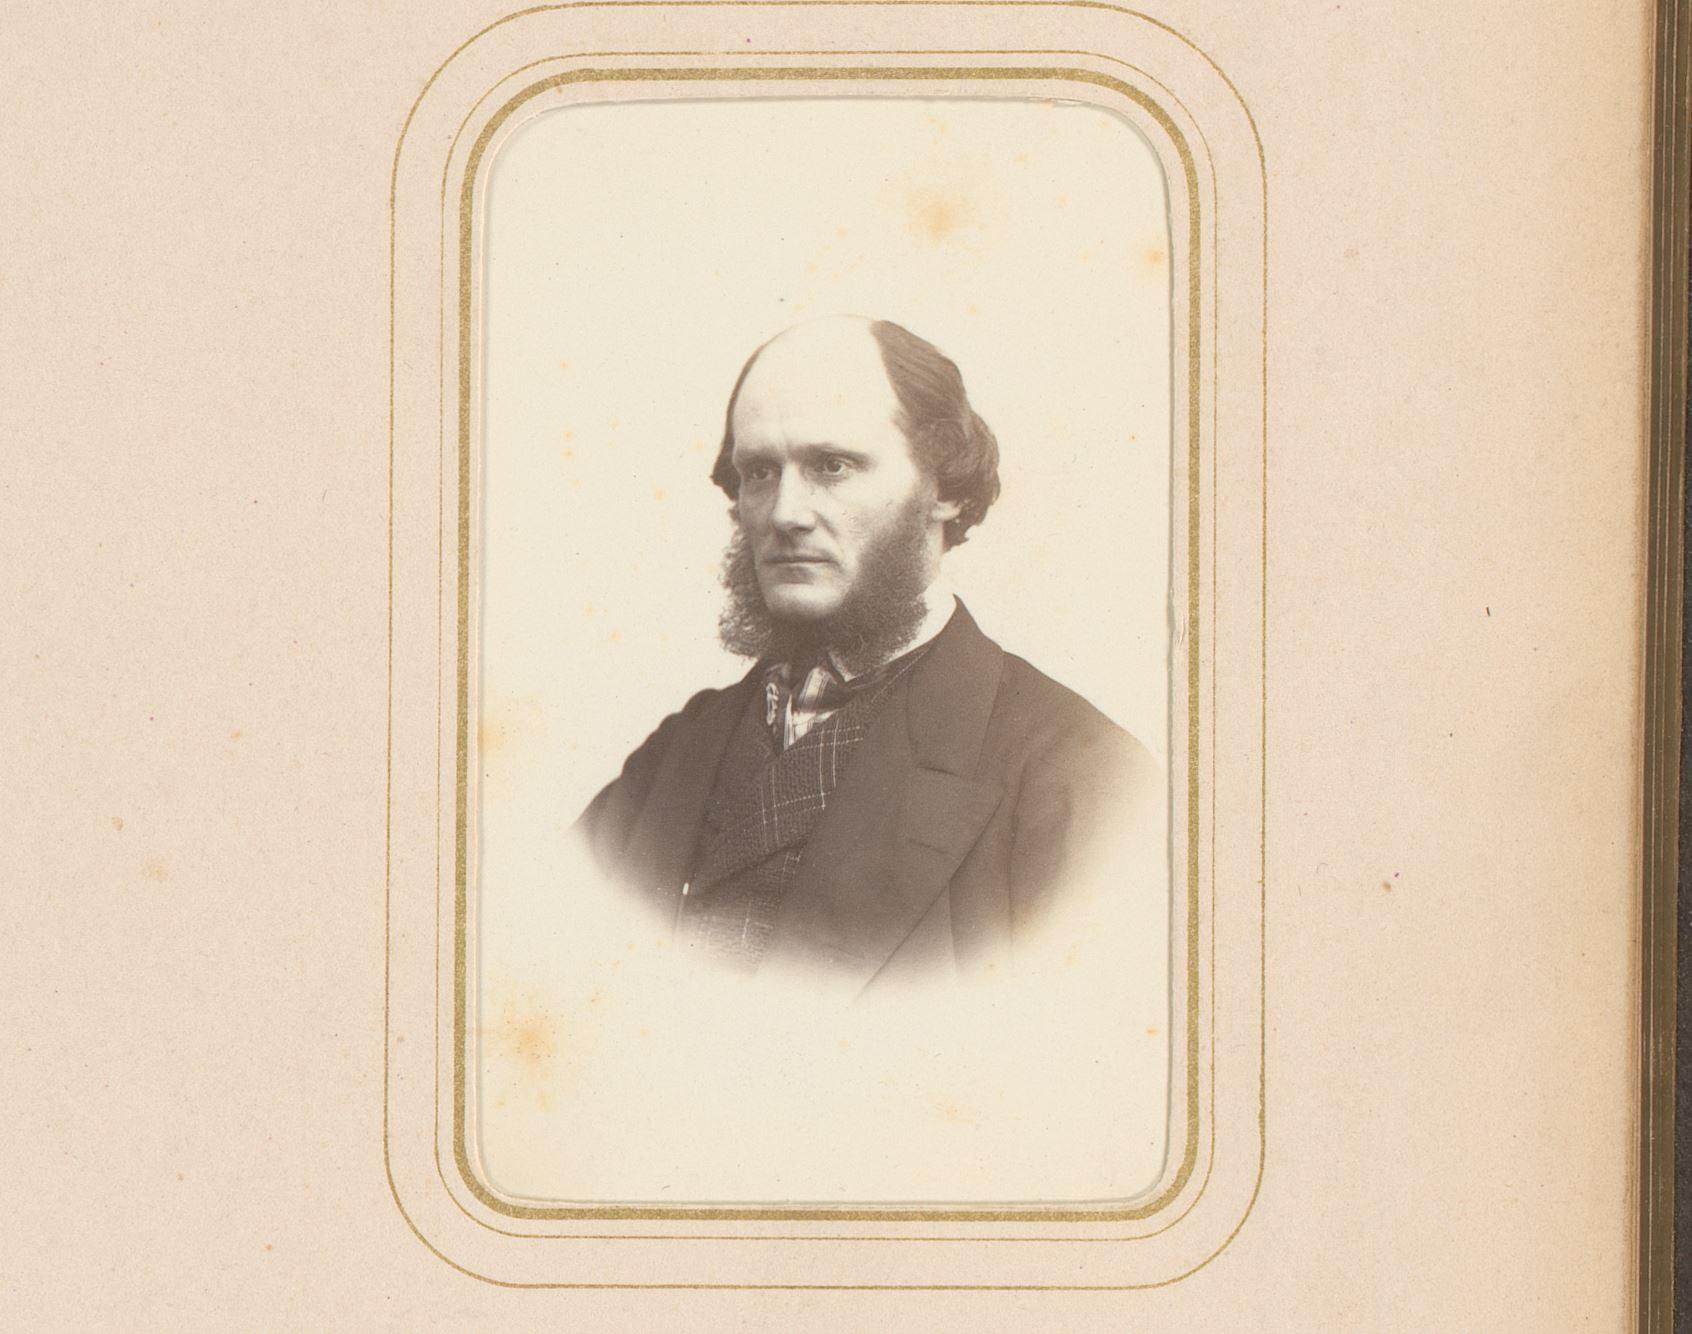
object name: photograph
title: Portret van een man met baard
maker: adolphus henry augustin wing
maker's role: fotograaf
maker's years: 1822-1906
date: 1863-1867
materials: cardboard, photographic support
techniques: albumen print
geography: london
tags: historical persons, beard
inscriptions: inscription: ‘Mr. ADOLPHUS WING/ 48 PICCADILLY/ Entrance in/ ALBANY YARD.’